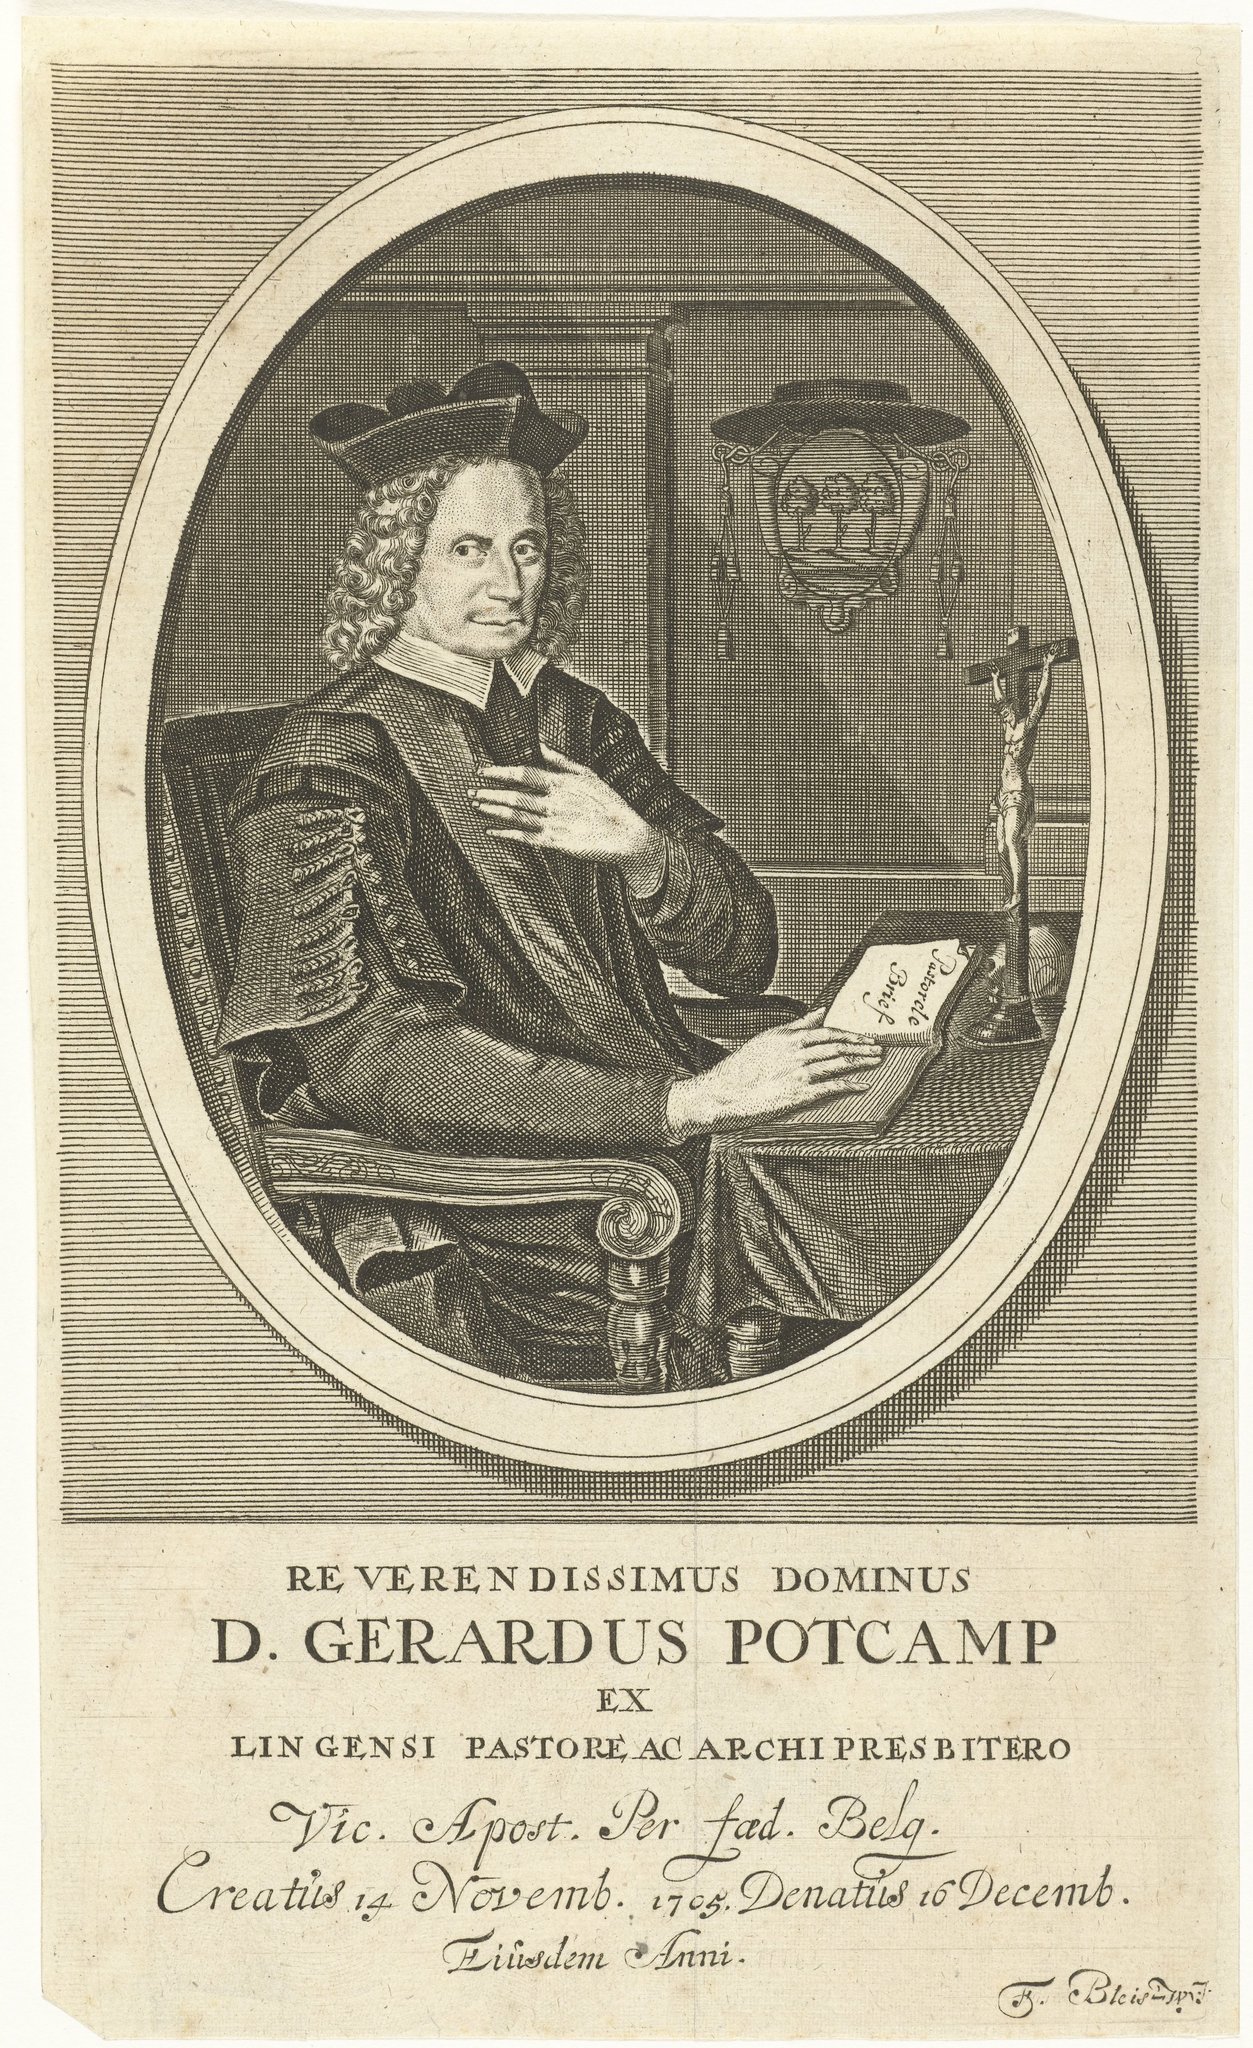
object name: print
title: Reverendissimus dominus D. Gerardus Potcamp (...) 16 December Euisdem Anni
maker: françois van bleyswijck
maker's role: draughtsman, print maker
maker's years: 1671-1746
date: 1681-1726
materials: paper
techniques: engraving, etching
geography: leiden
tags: gerard potcamp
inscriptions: collector's mark: Lugt 2228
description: Prent later gebruikt in: Heussen, Hugo Franciscus van & Hugo van Rijn, Kerkelijke historie en outheden der Zeven Vereenigde Provincien, 6 delen, Leiden, Dirk Haak & Samuel Luchtmans & Johan Arnold Langerak, 1726